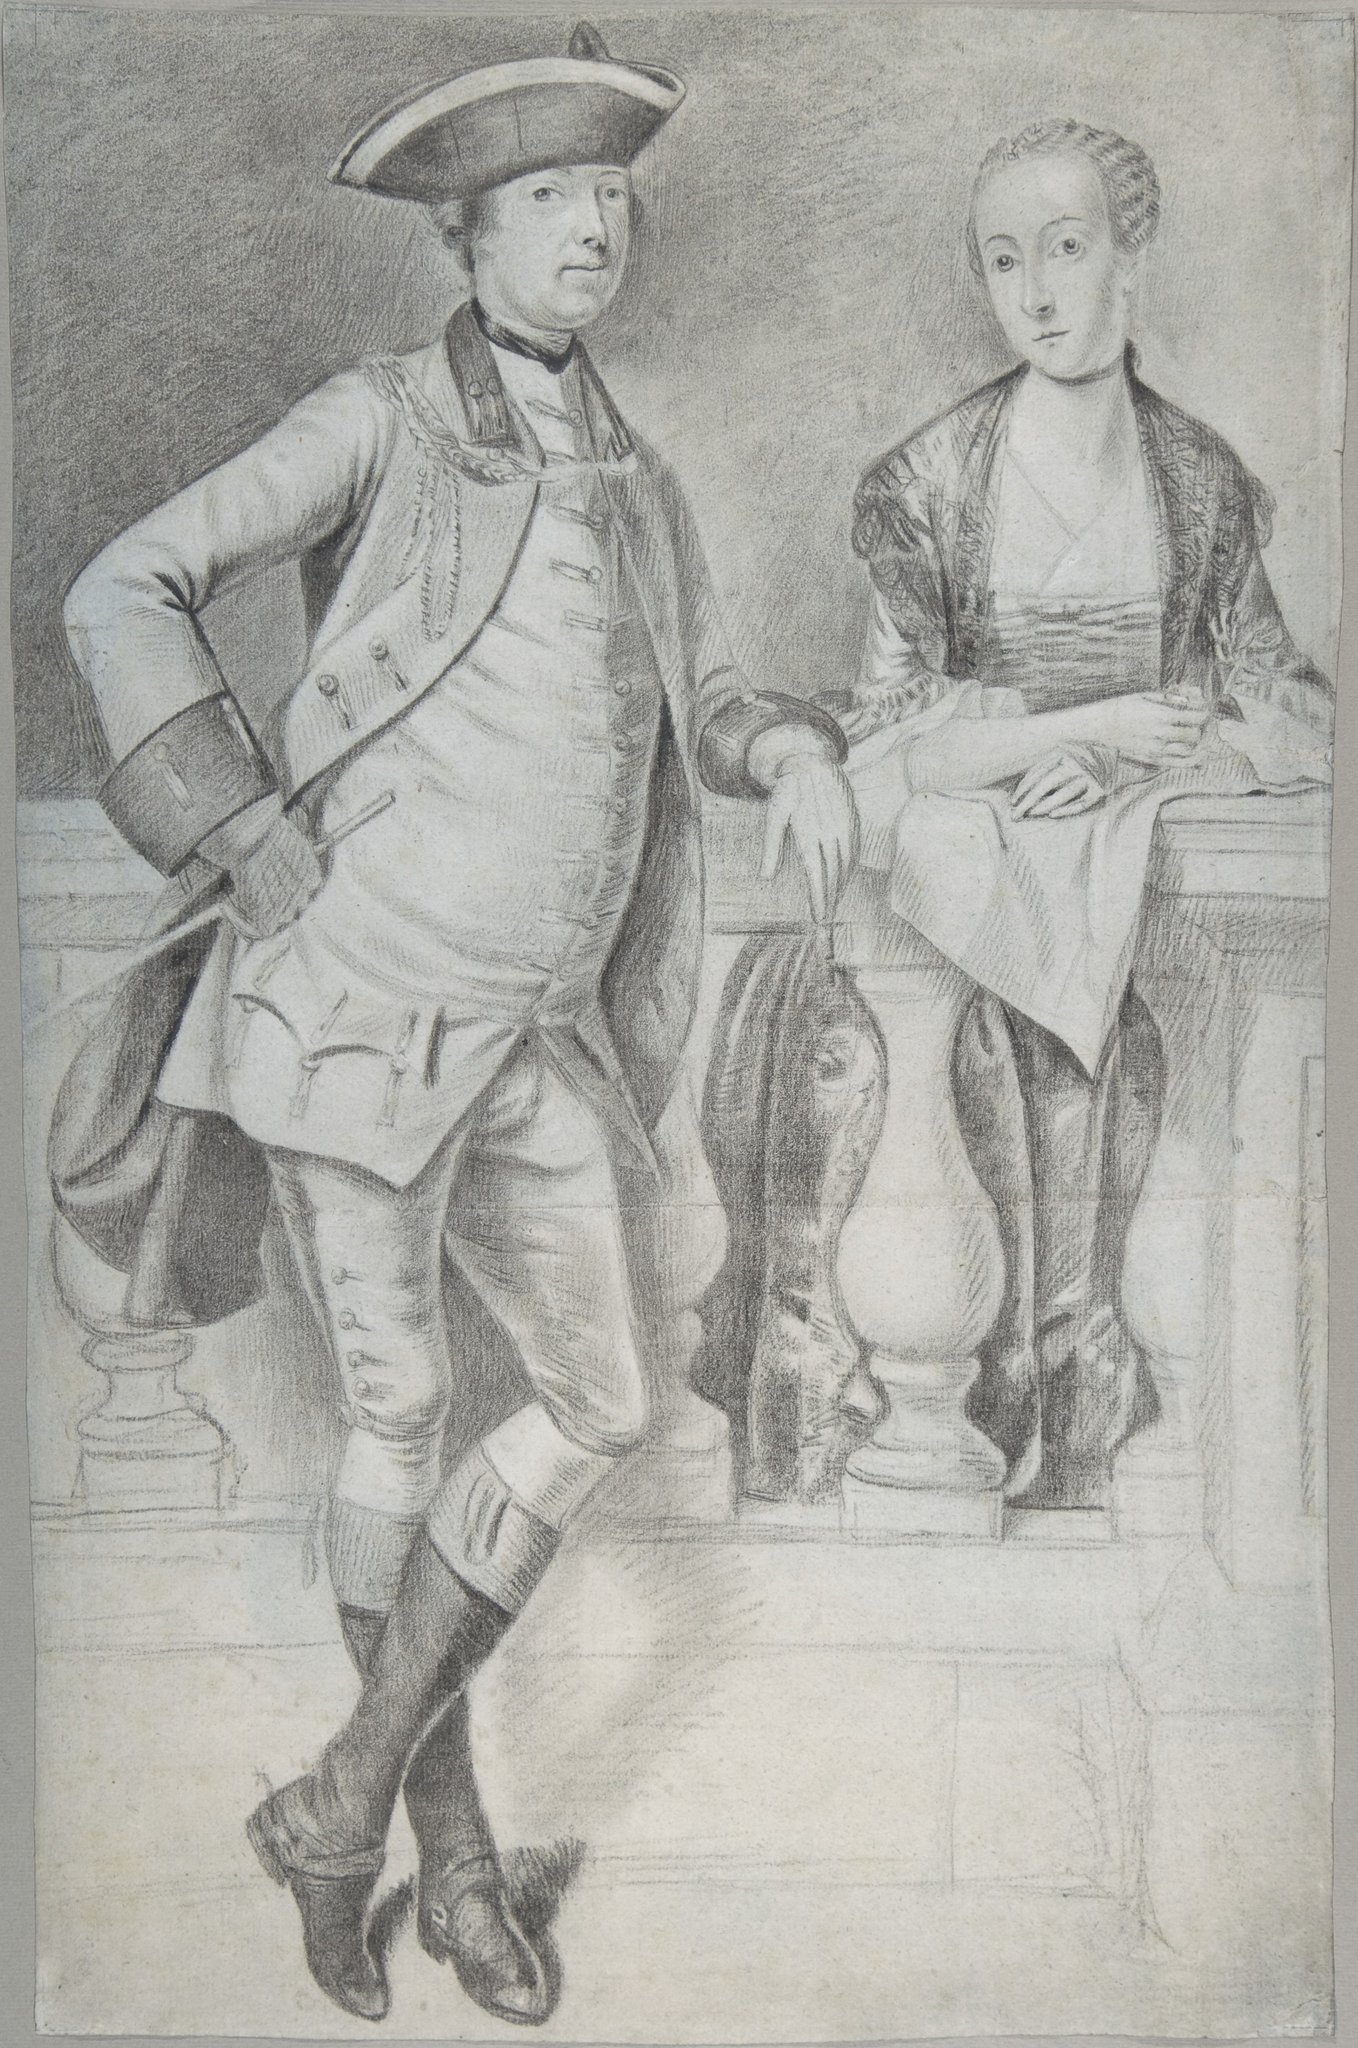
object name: drawing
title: Study for a Portrait of an Officer and His Wife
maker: arthur devis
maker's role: artist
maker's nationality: british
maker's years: 1712-1787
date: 1756-1758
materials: chalk, ink, paper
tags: men,women